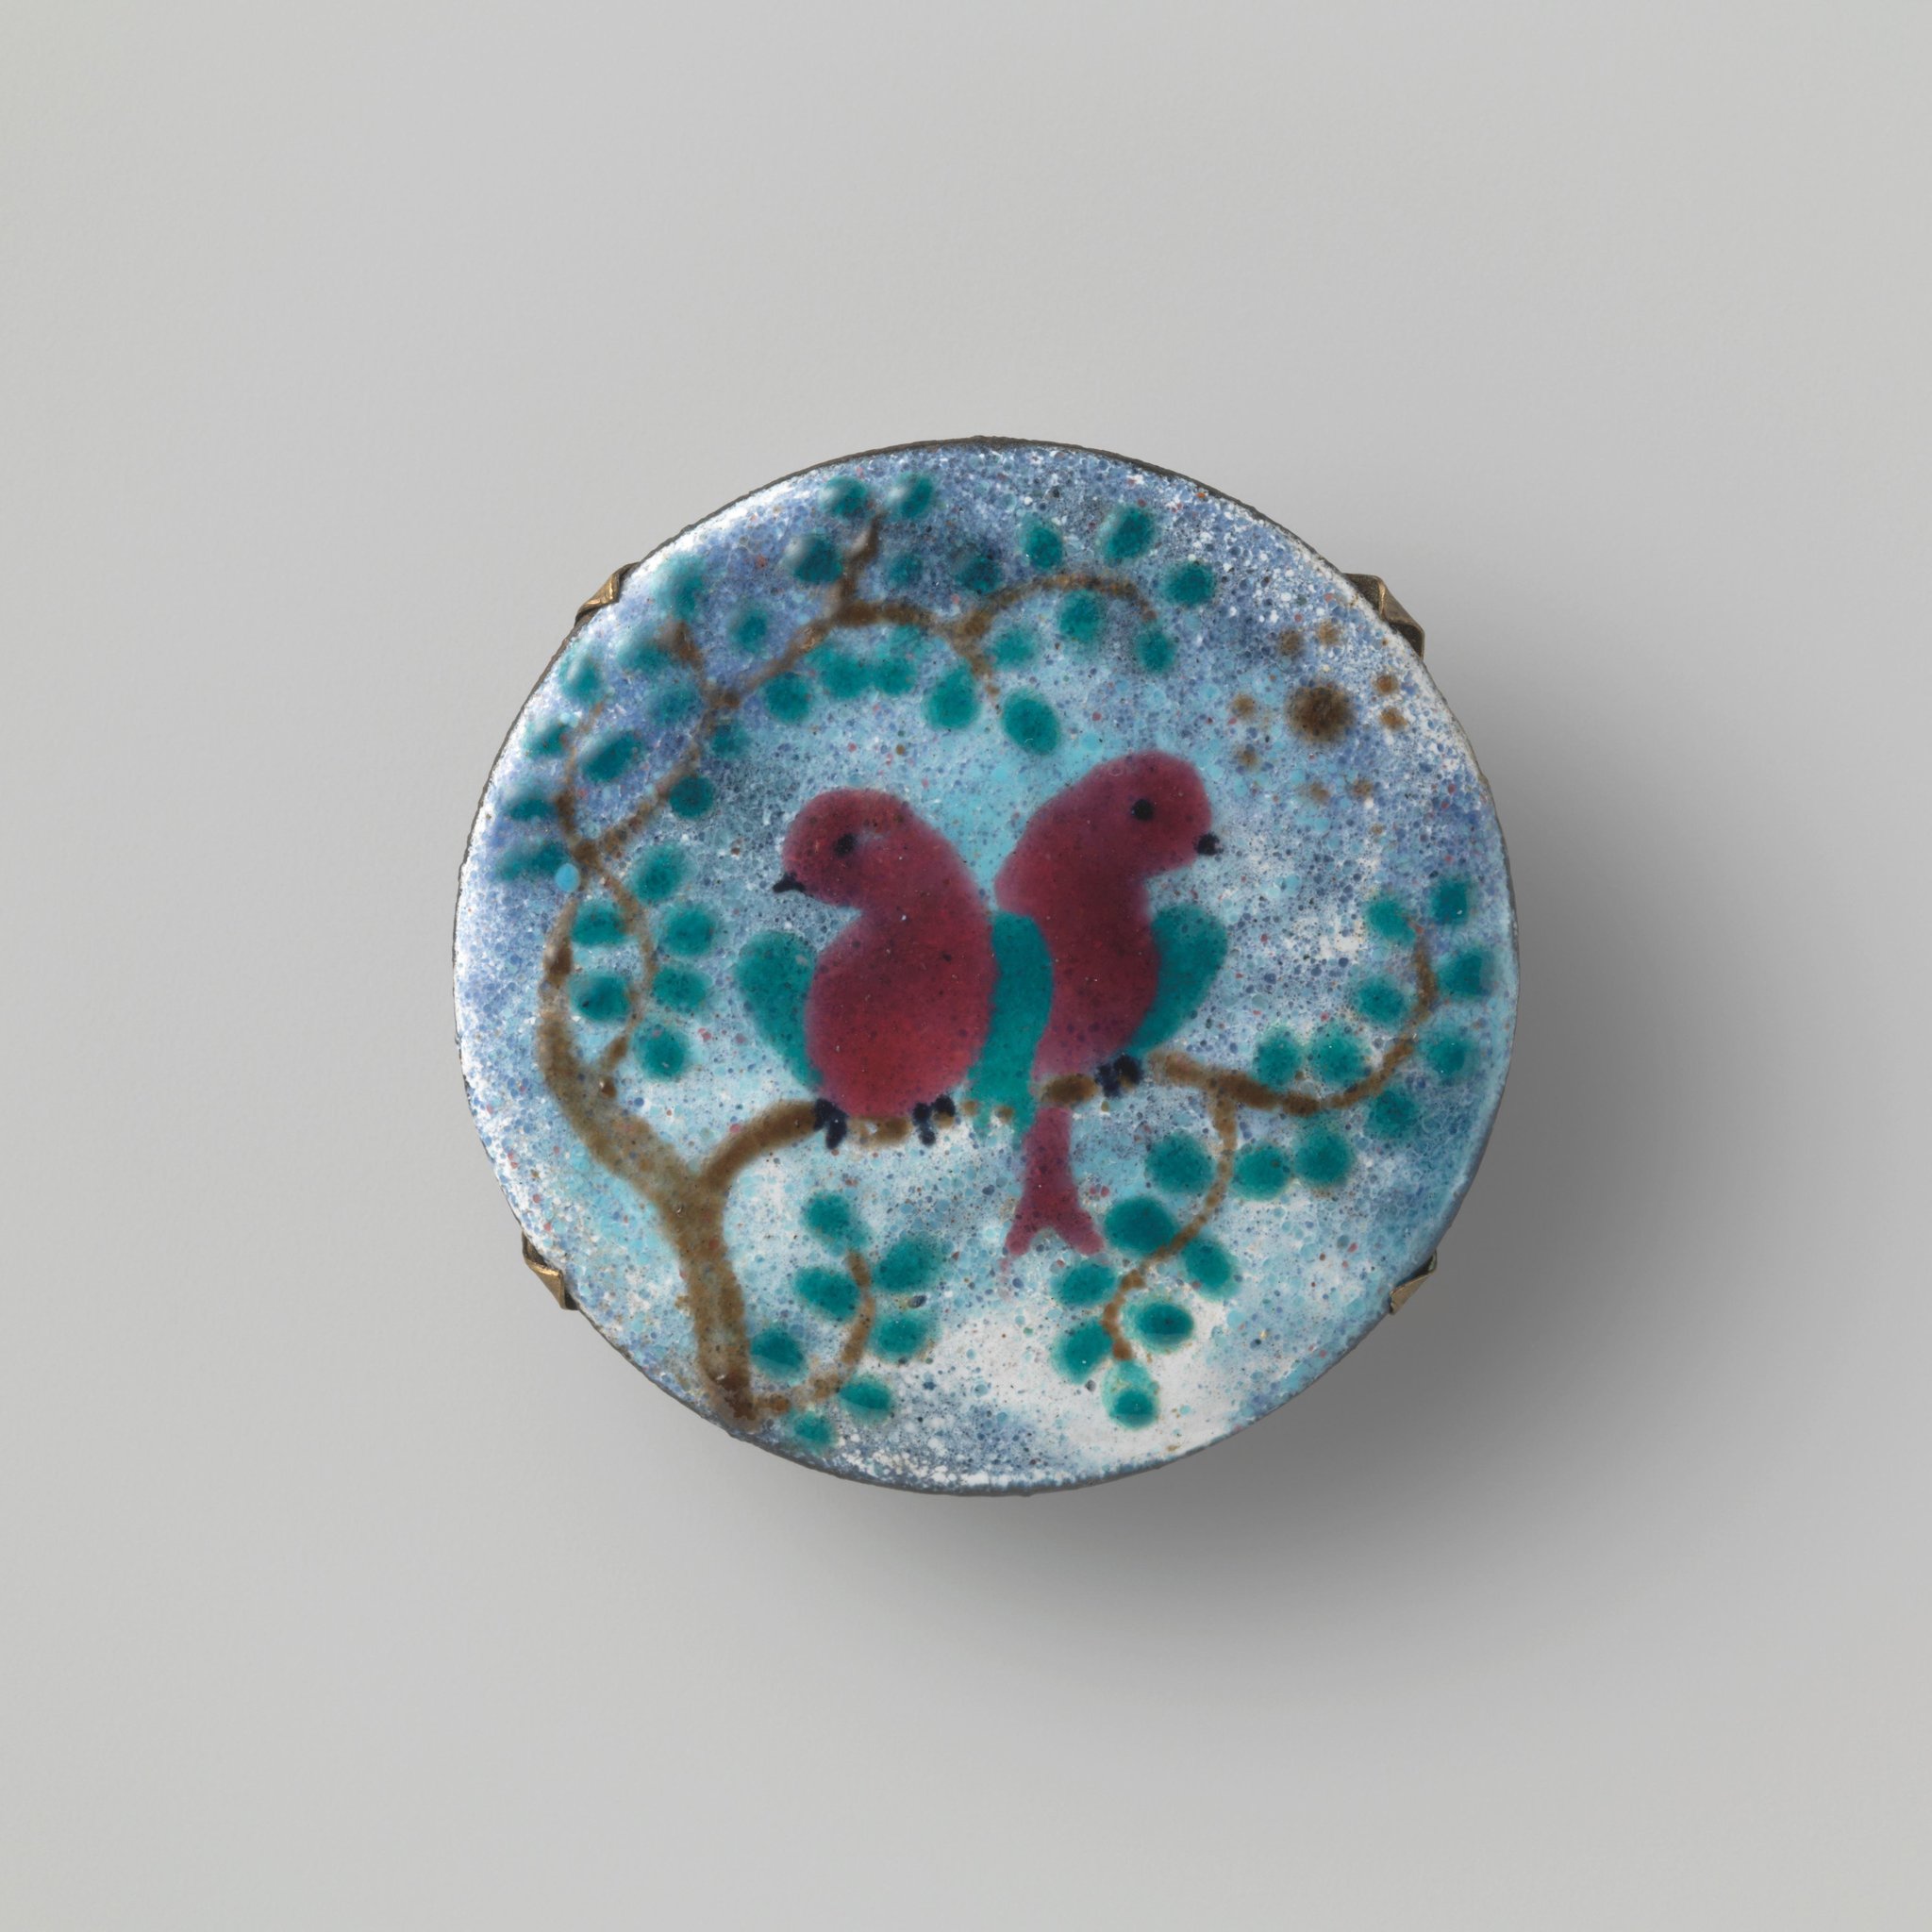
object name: brooch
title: Ronde broche van email op koper met twee vogels op een tak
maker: Anonymous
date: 1950-1960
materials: copper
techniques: enameling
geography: netherlands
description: Ronde broche van email op koper voorzien van een haaksluiting. De rechthoekige brochering is met vier hoeken om de ronde plaat gezet. De twee vogels op een tak zijn rood en hebben groene vleugels. De achtergrond is blauw en wit gevlekt.